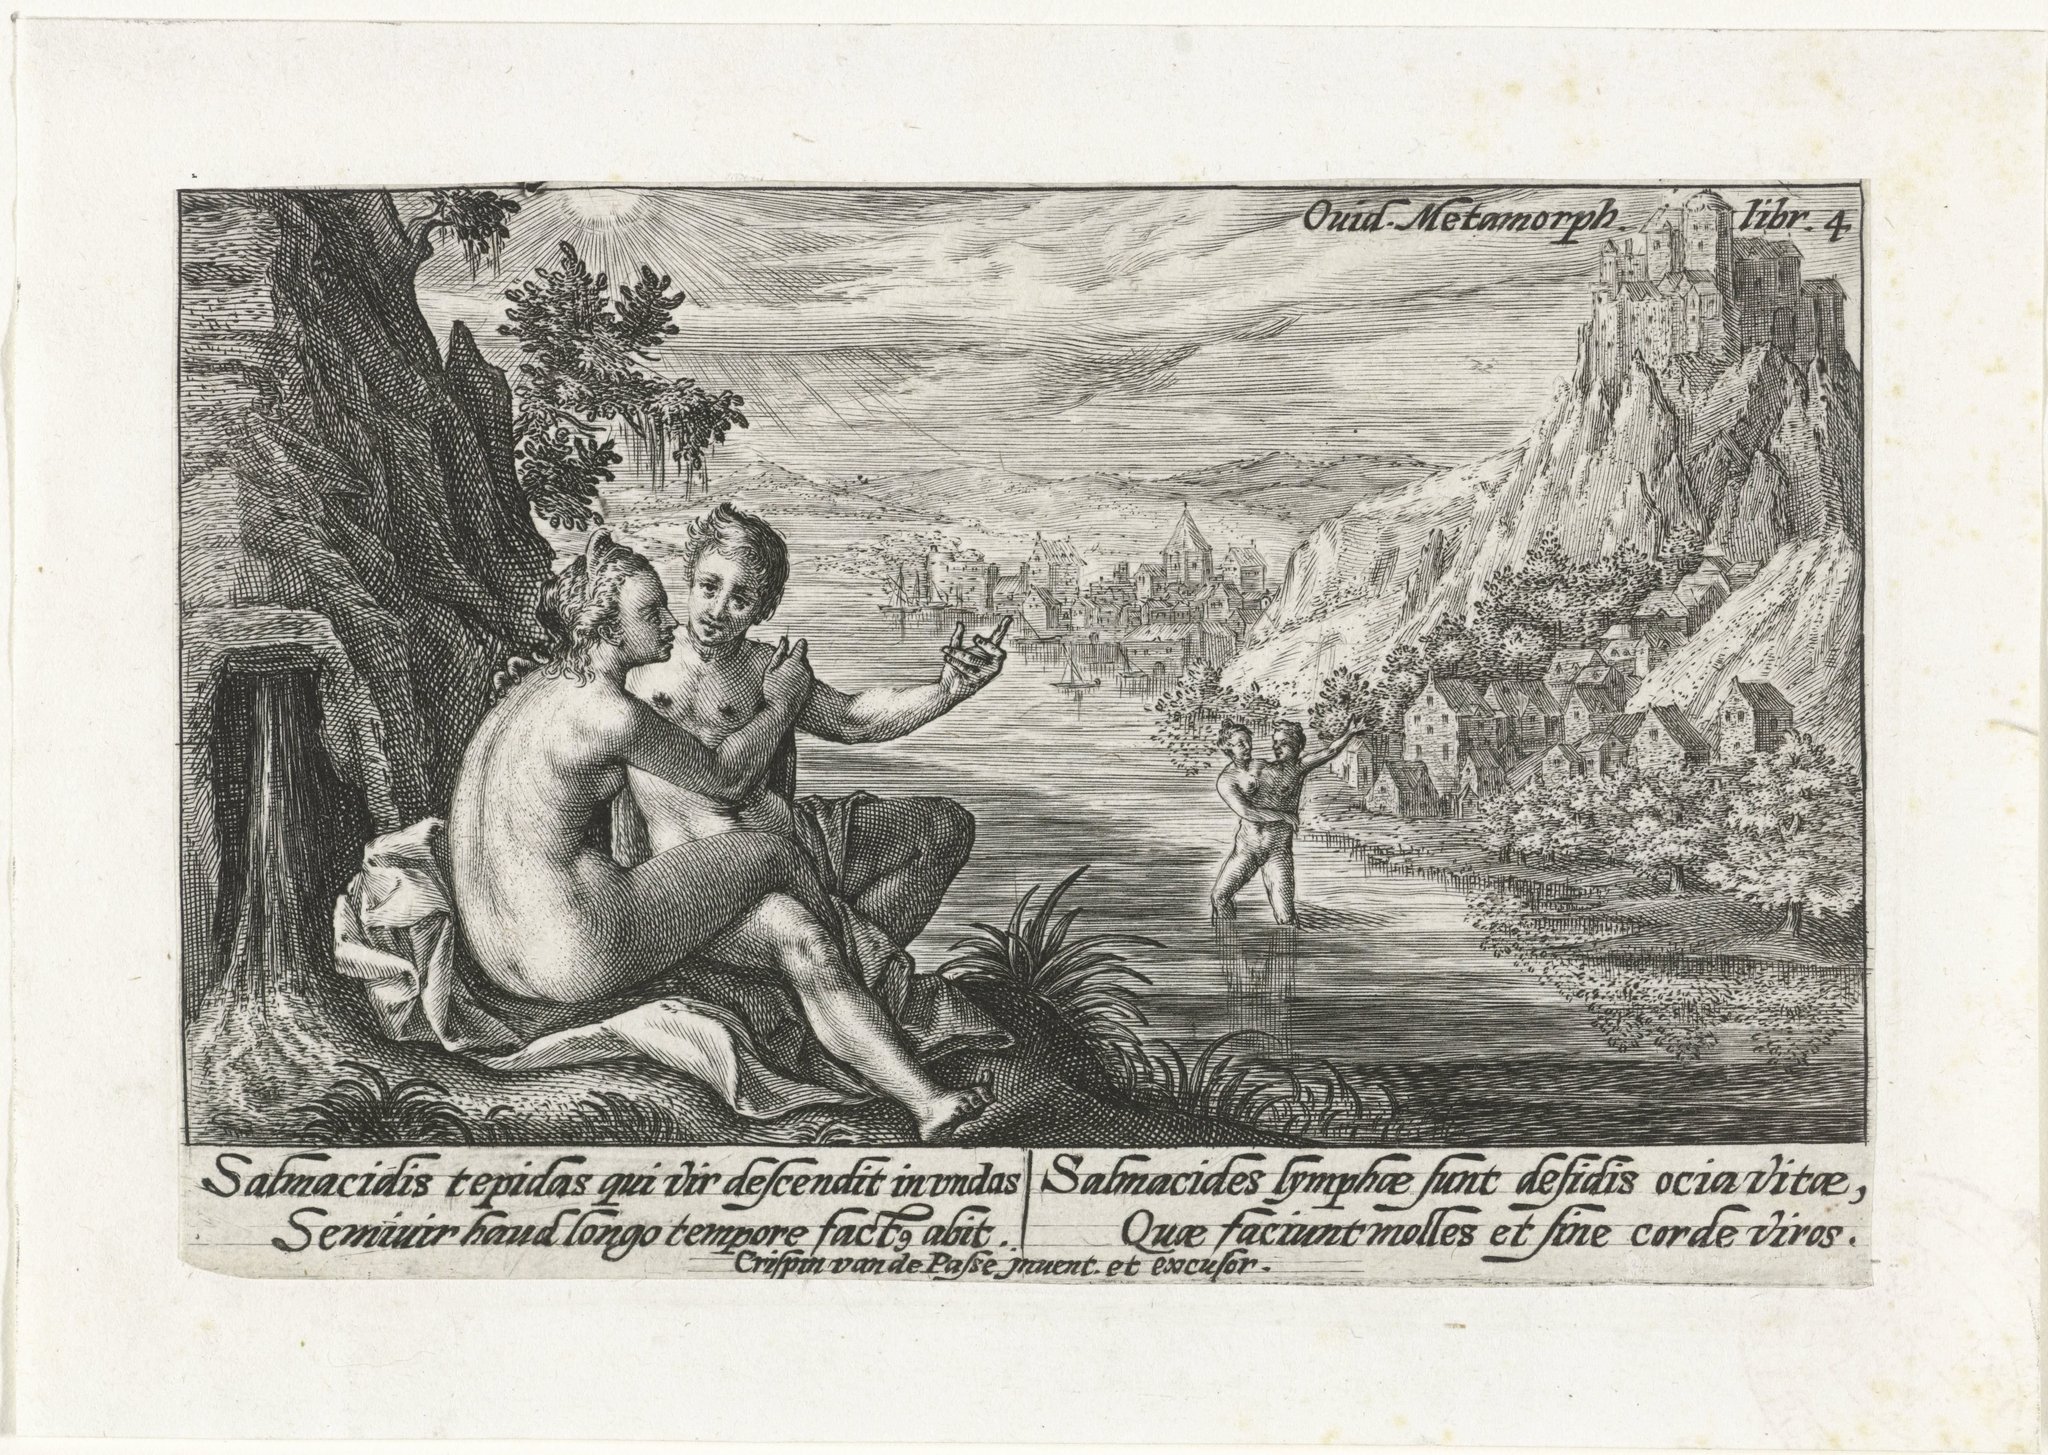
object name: print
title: Salmacis en Hermaphroditus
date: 1602-1607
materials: paper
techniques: engraving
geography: cologne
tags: story of hermaphroditus and salmacis, hermaphroditus and salmacis changed into a hermaphrodite: at the prayer of the fountain-nymph salmacis, who holds the bathing hermaphroditus closely embraced, their bodies fuse (ovid, metamorphoses iv 373)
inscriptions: collector's mark: Lugt 240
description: Salmacis, een van Diana's nimfen, en Hermaphroditus aan de rand van het meer waarin Salmacis woonde. Salmacis werd verliefd op Hermaphroditus en klemt zich aan hem vast zodat hun lichamen versmelten. Op de achtergrond, in het meer, is de versmelting gaande. In de marge een vierregelig onderschrift, in twee kolommen, in het Latijn.